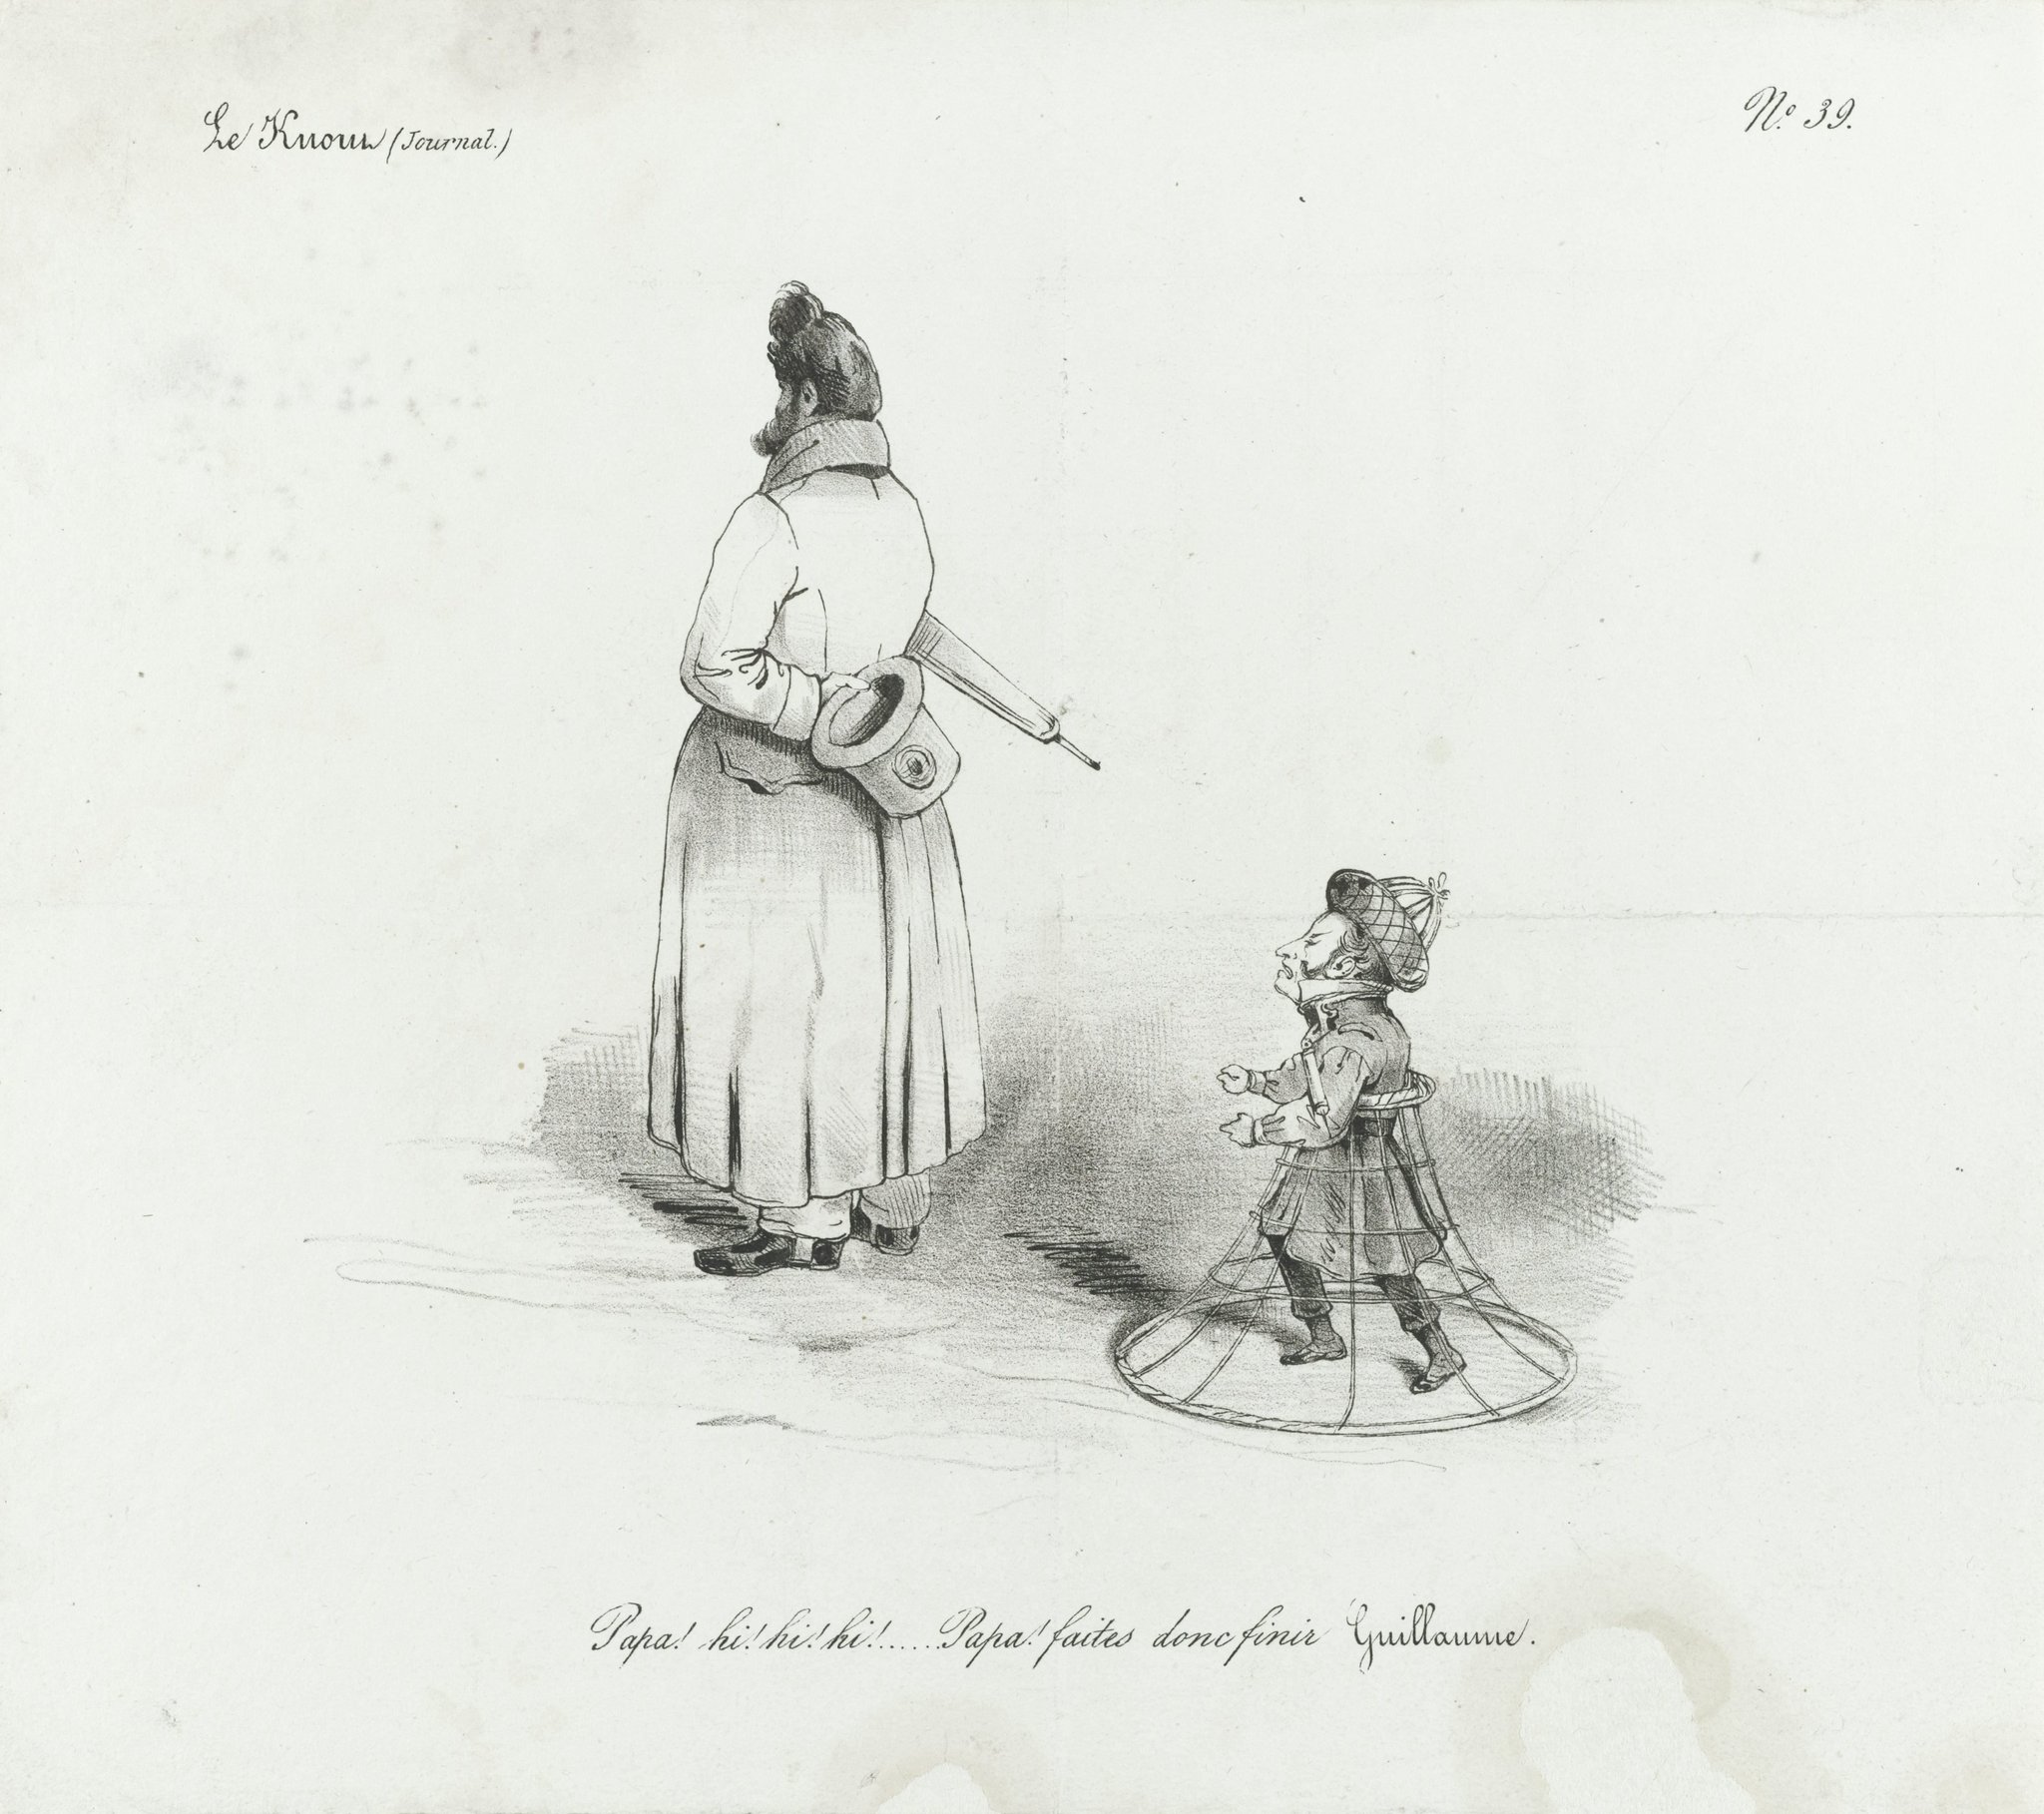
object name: print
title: Papa! hi!hi!hi! (...) Papa! faites donc finir Guillaume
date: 1832-1834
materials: paper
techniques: lithograph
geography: brussels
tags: the hague, berlin, william i of the netherlands, laeken, leopold i (koning der belgen), paris, lodewijk filips i (koning van frankrijk), implements for learning to walk, go-cart, head-protector (~ learning to walk)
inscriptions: collector's mark: Lugt 2228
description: Spotprent op de Belgische koning Leopold I. Koning Leopold die als een boos kindje met valhelm en looprek zeurt bij zijn vader, koning Lodewijk Filips van Frankrijk, over koning Willem I. Bovenaan gemerkt: Le Knout (Journal.) No. 39.